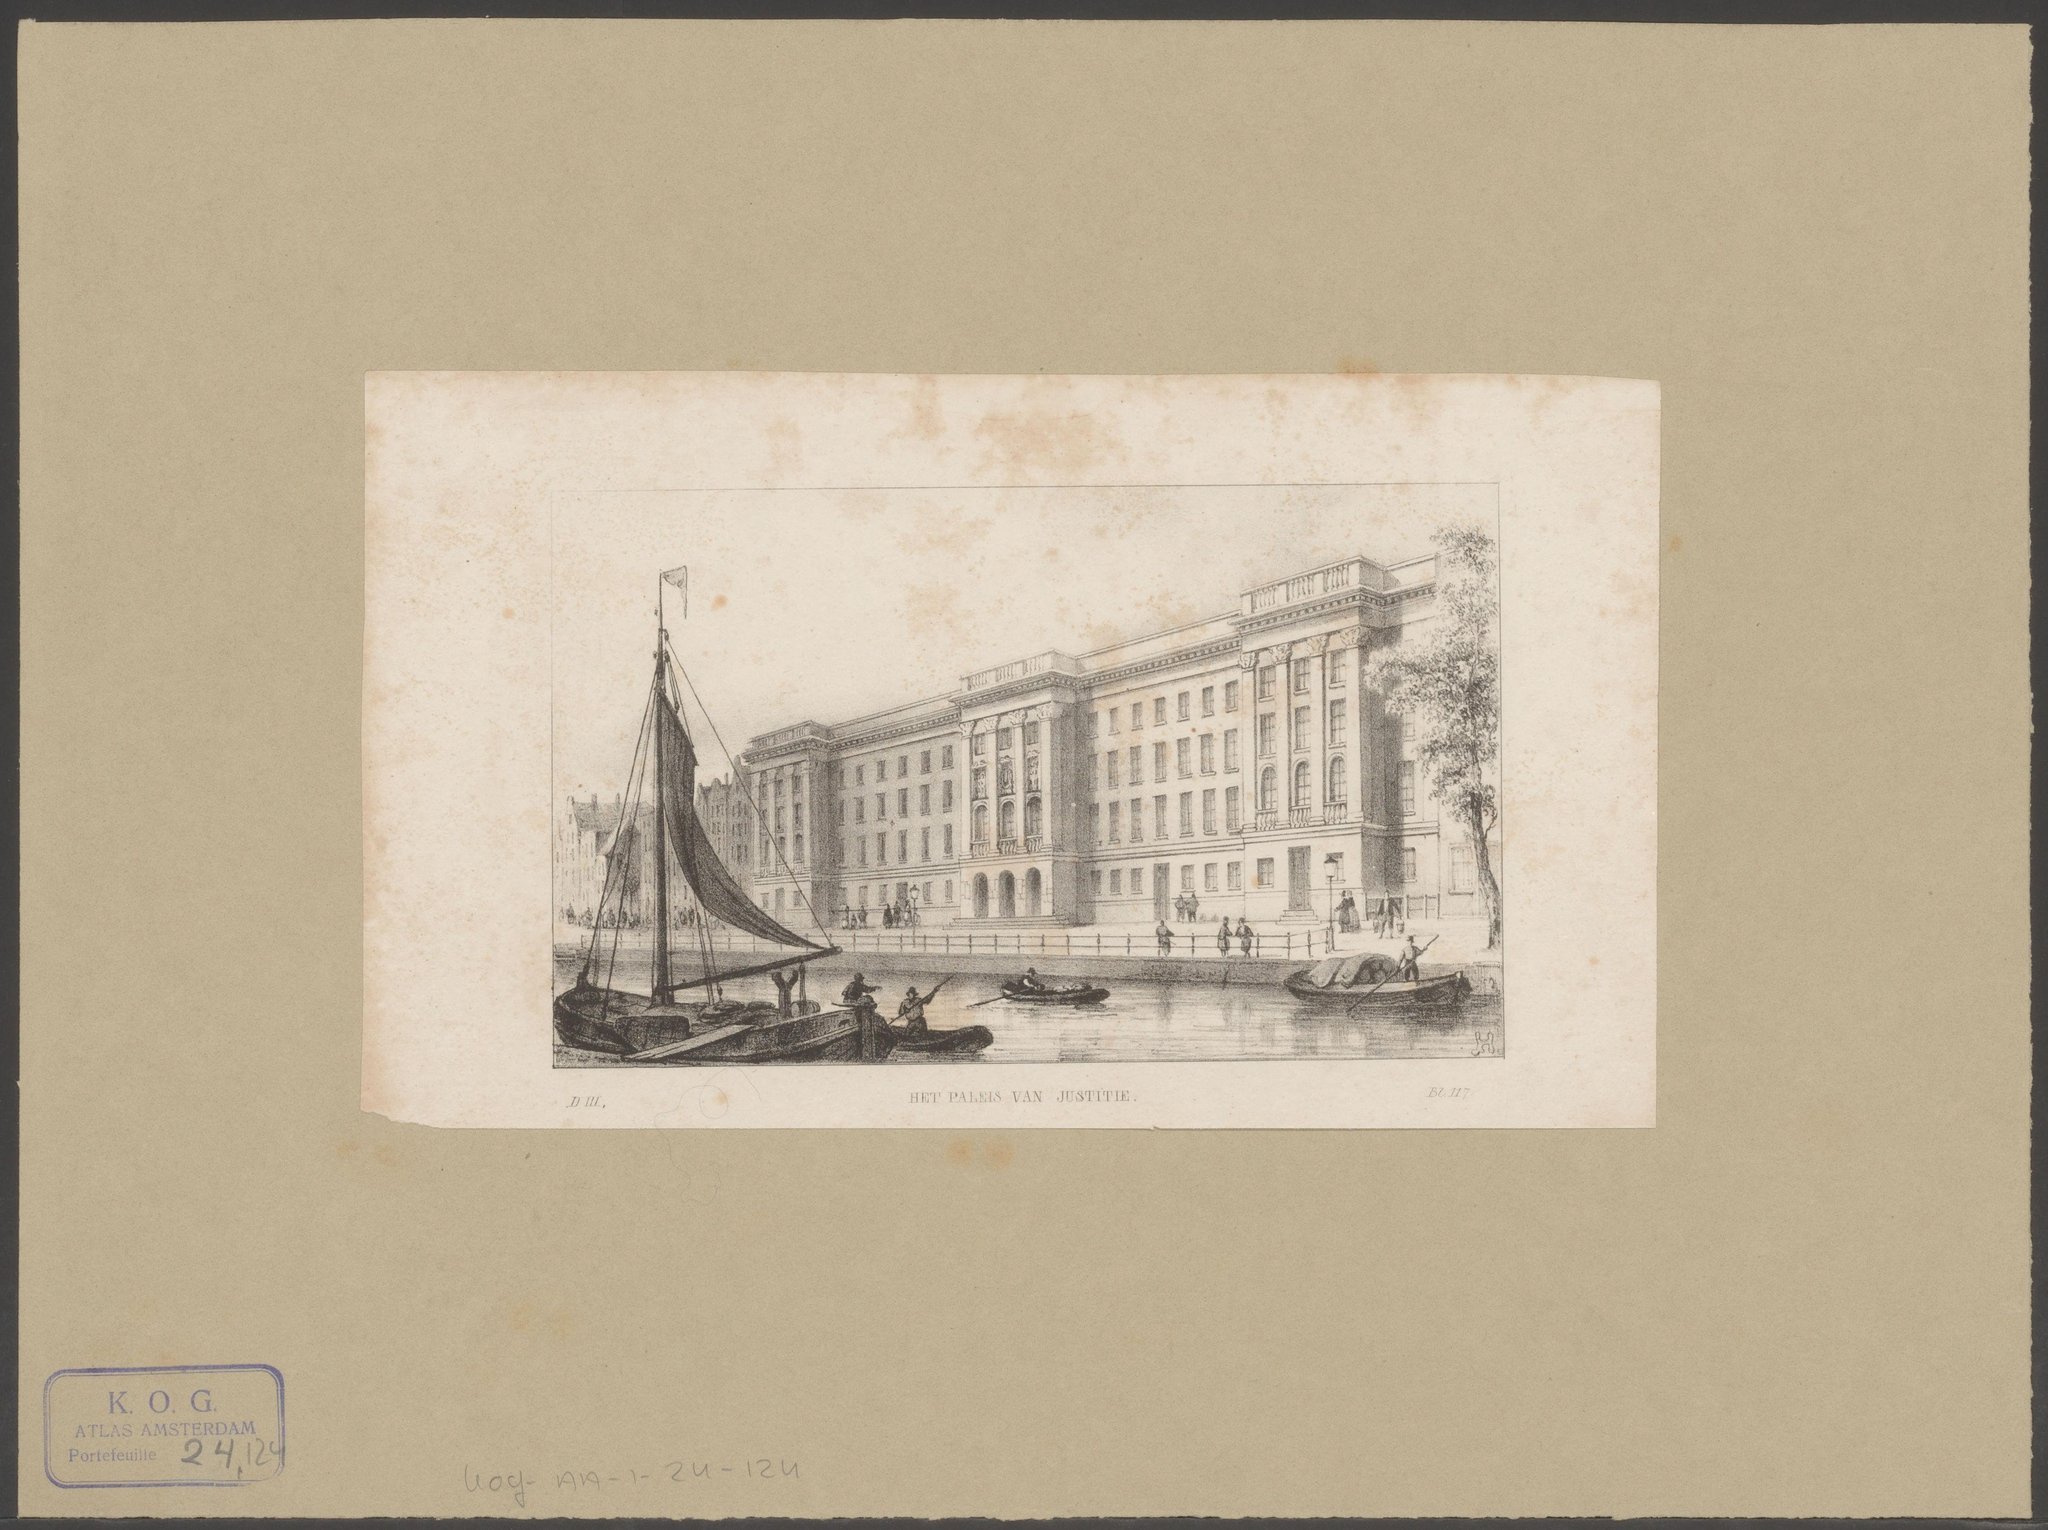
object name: book illustration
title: Het Paleis van Justitie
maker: johannes hilverdink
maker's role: draughtsman, painter, print maker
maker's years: 1813-1902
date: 1846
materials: paper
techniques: lithograph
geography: netherlands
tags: court building, sailing-ship, sailing-boat, city-view in general; 'veduta', canals, waters (in city), boat propelled by man or animal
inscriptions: collector's mark: Lugt 1641b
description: Prent uit: Vijver, Cornelis van der. Geschiedkundige Beschrijving der Stad Amsterdam (...). Amsterdam: Gebroeders Diederichs, 1846, dl. 3.